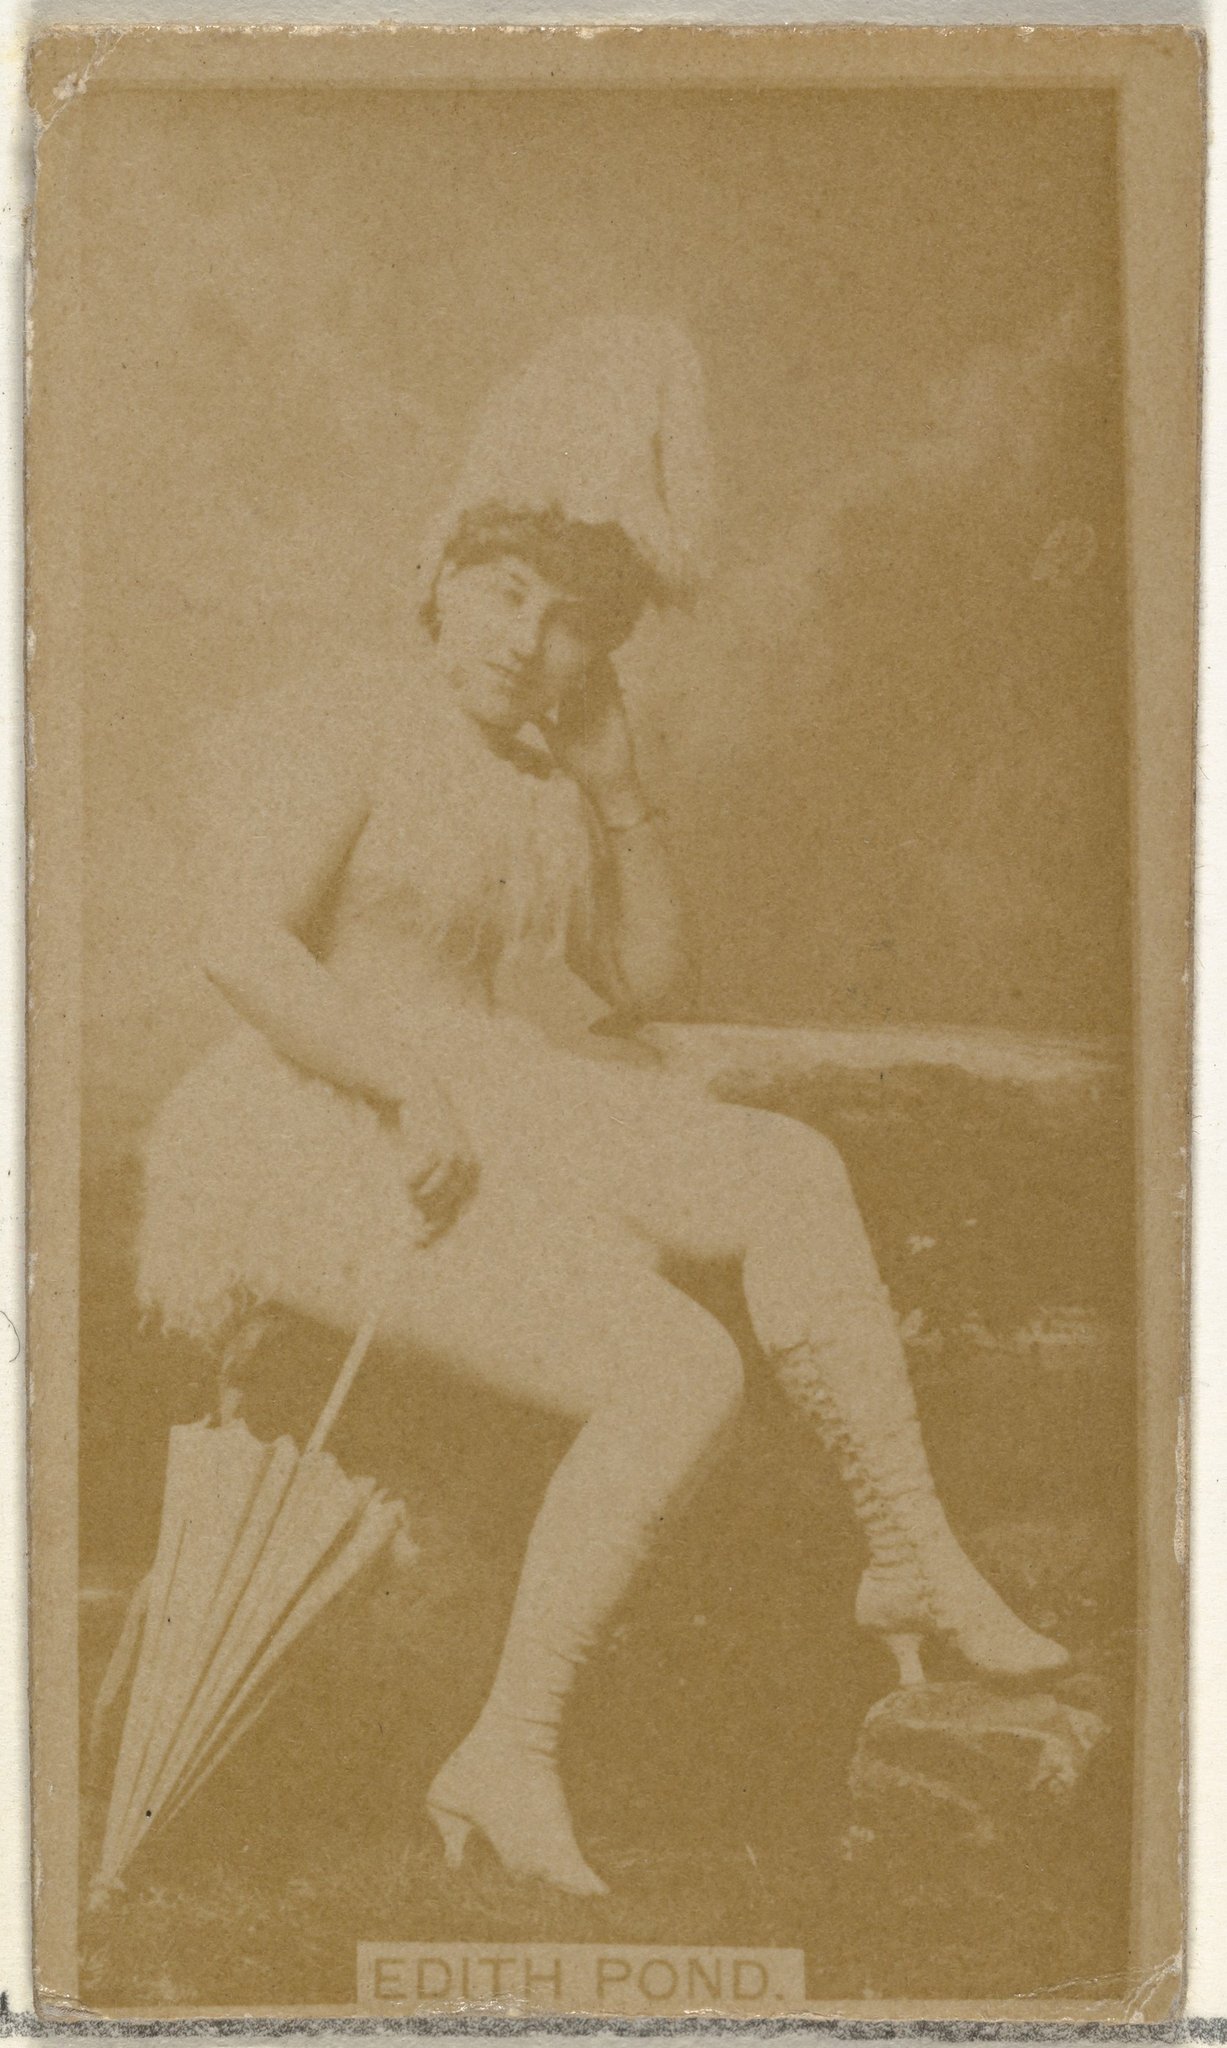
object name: photograph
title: Edith Pond, from the Actors and Actresses series (N145-8) issued by Duke Sons & Co. to promote Duke Cigarettes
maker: w. duke, sons & co.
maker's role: publisher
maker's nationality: american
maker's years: 1870-1920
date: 1891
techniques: albumen silver print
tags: portraits,women,actresses